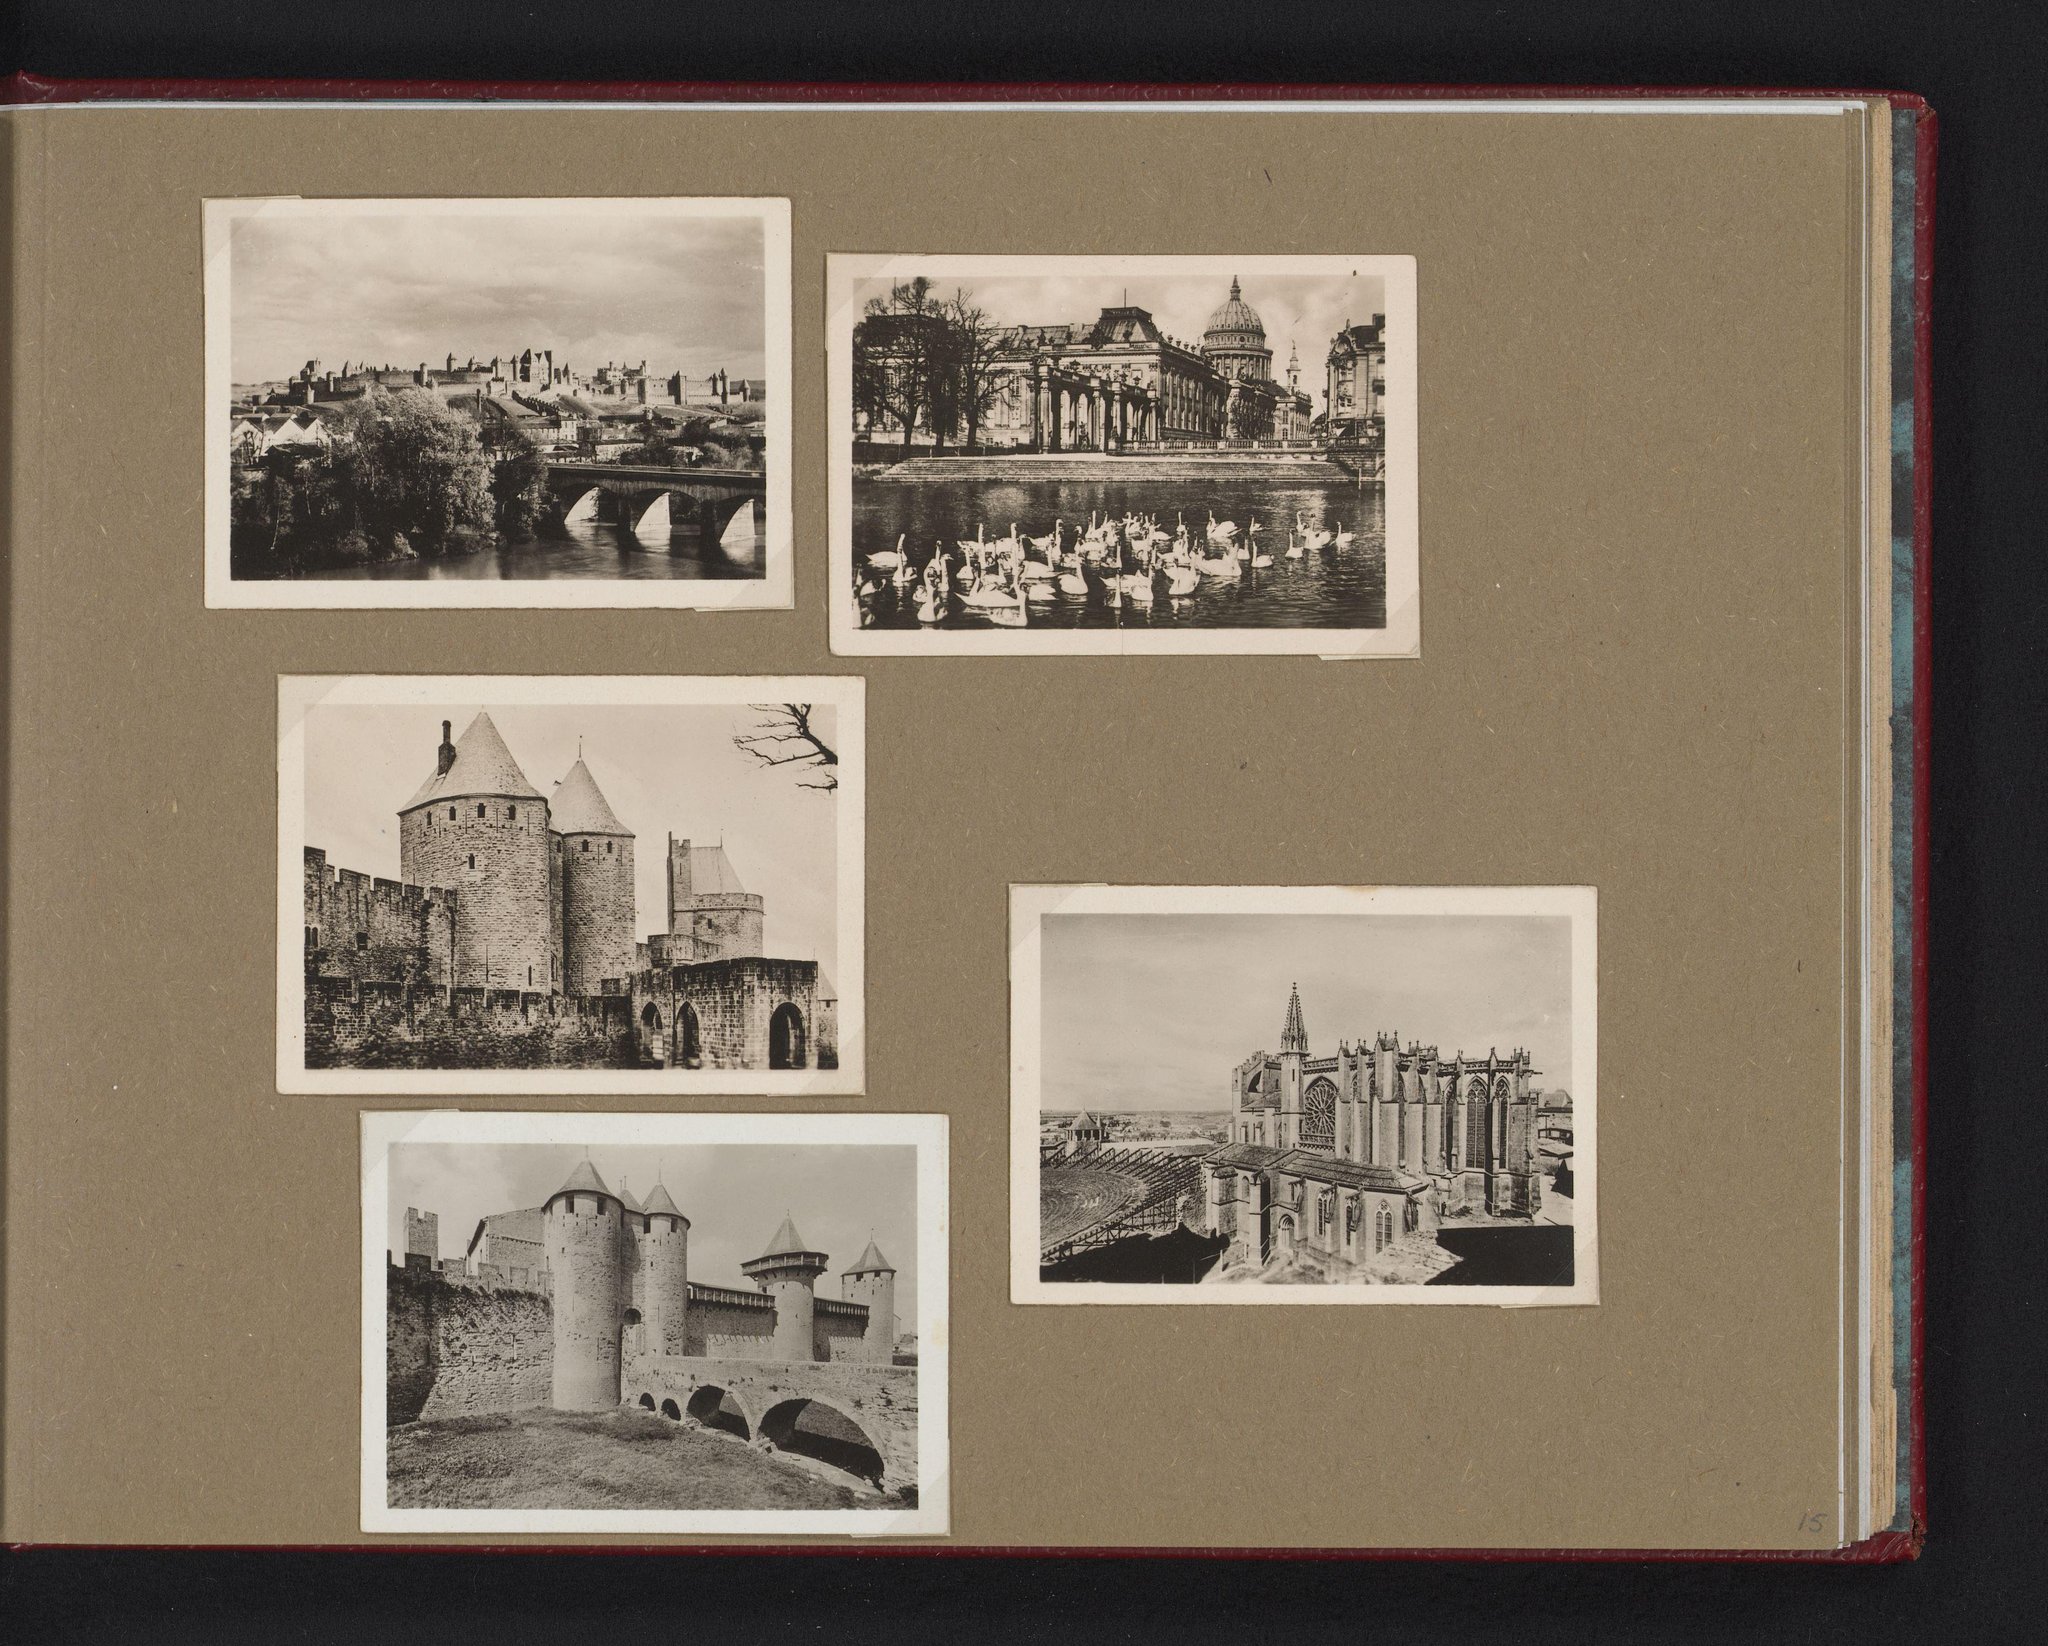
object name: album leaf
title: Carcassonne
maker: Anonymous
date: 1935-1943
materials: paper, photographic support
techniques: gelatin silver print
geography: france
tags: city-view in general; 'veduta'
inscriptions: inscription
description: Albumblad met vijf (gekochte) foto's van stadsgezichten te Carcassonne en Potsdam. Onderdeel van het fotoalbum over soldaten van de Wehrmacht, ca. 1939-1943.